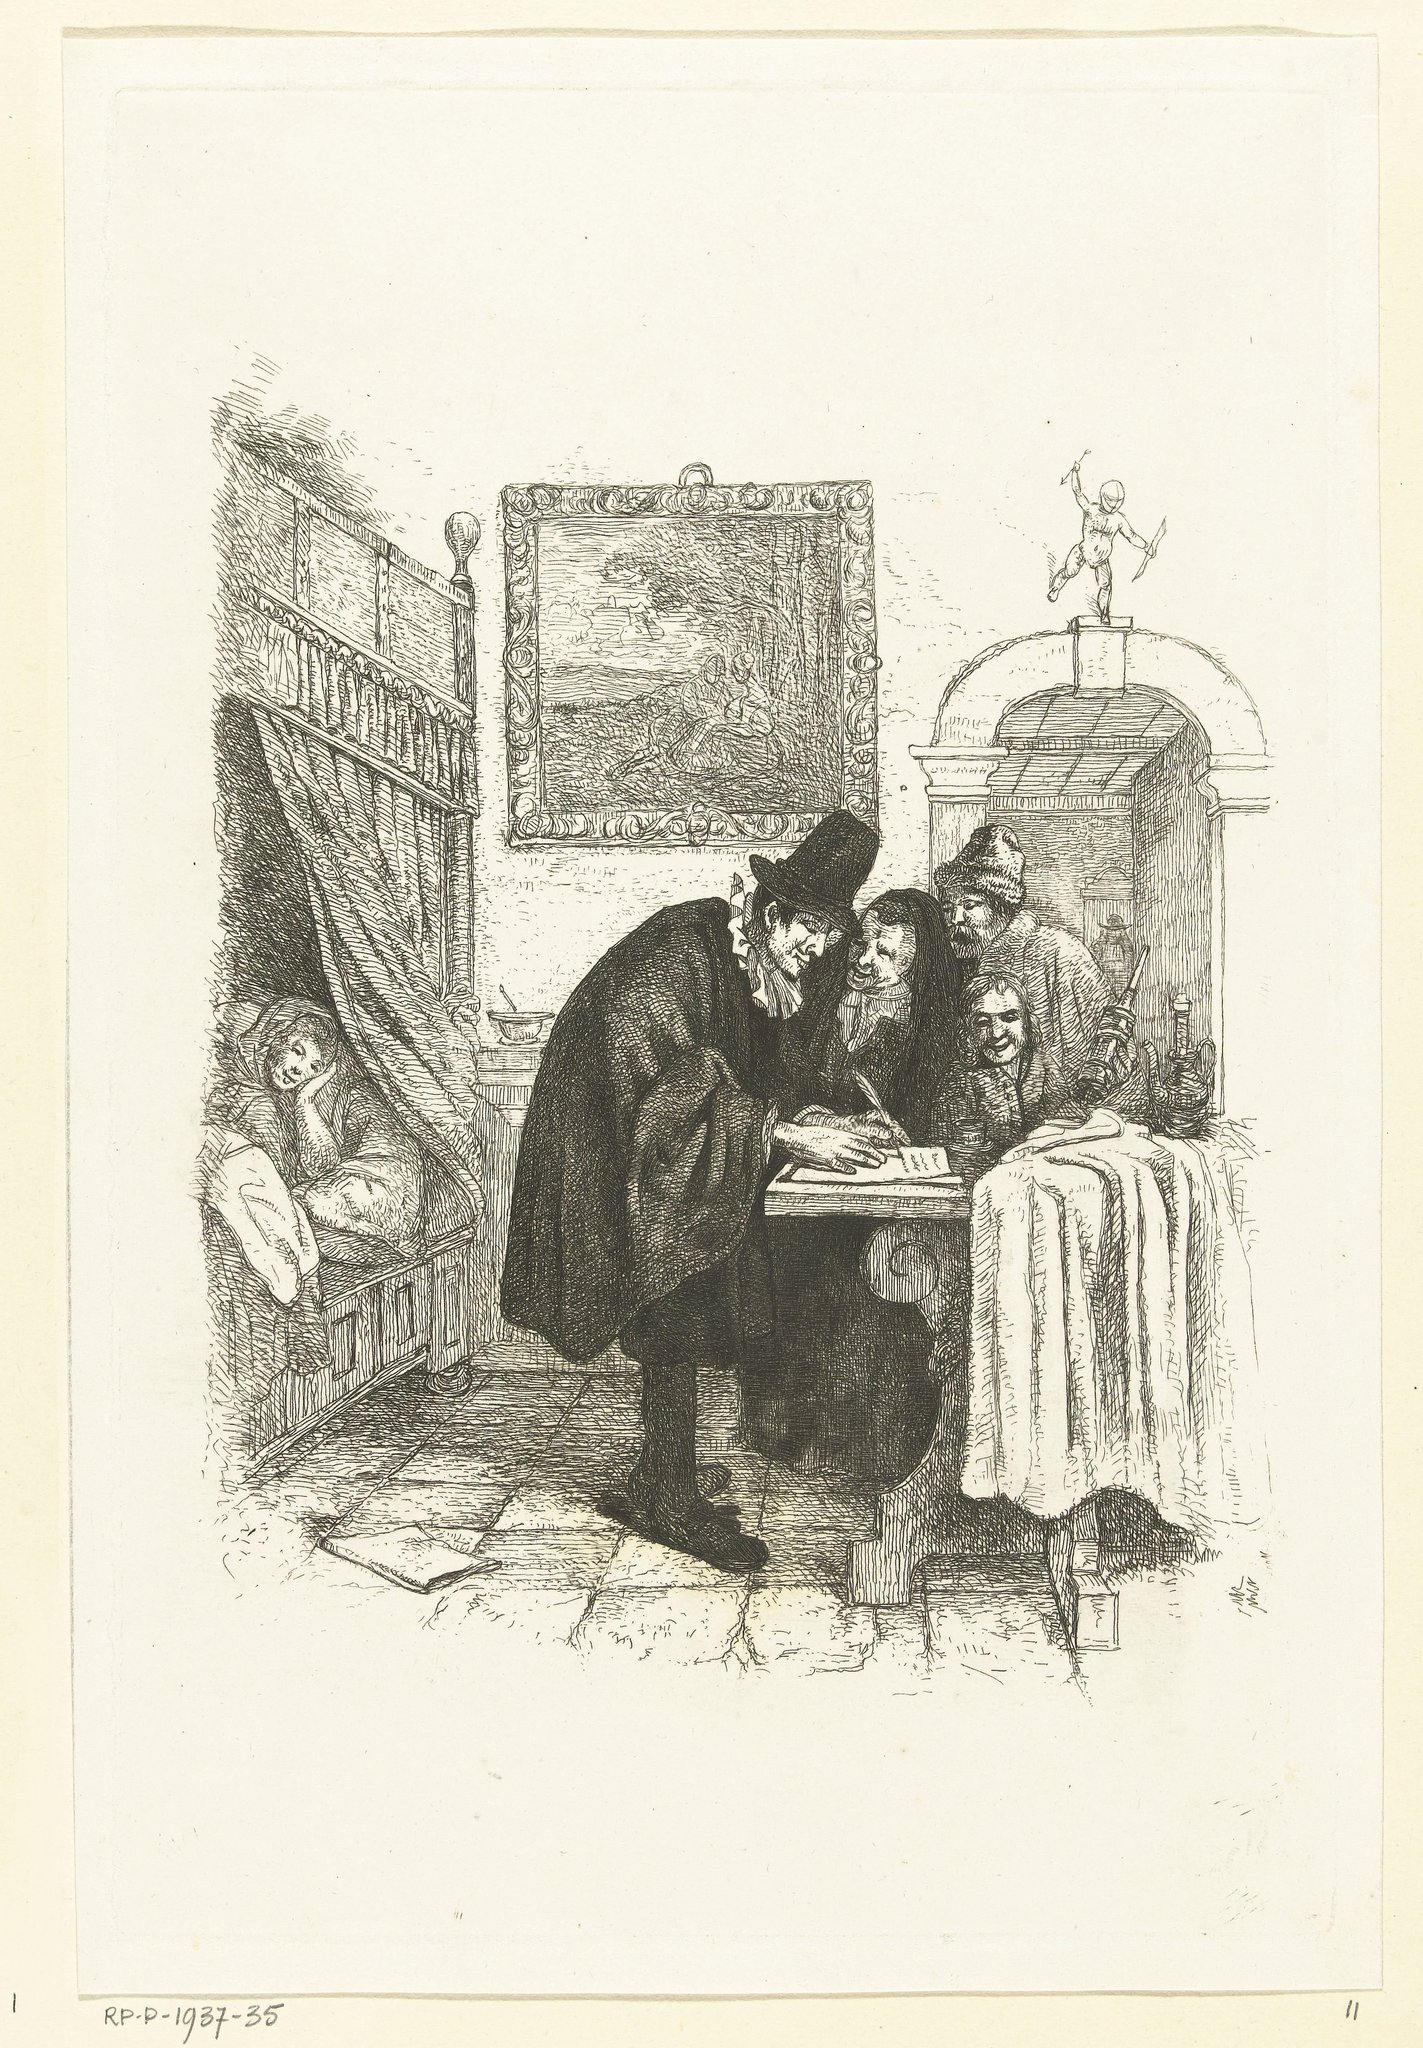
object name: print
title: Dokter op huisbezoek bij zieke vrouw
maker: albertus brondgeest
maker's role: draughtsman, print maker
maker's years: 1786-1849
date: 1796-1849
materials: paper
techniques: etching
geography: netherlands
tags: sick-bed, physician, doctor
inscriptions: collector's mark: Lugt 2760, collector's mark: Lugt 2228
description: Een dokter schrijft een recept staand aan een tafel. Een oude vrouw, een man met een klisteerspuit en een jongen kijken toe. De patient, een zieke vrouw, ligt in bed. In het interieur hangt een schilderij aan de wand met een pastorale scène. Bovenop de toog staat een klein beeldje van Amor.